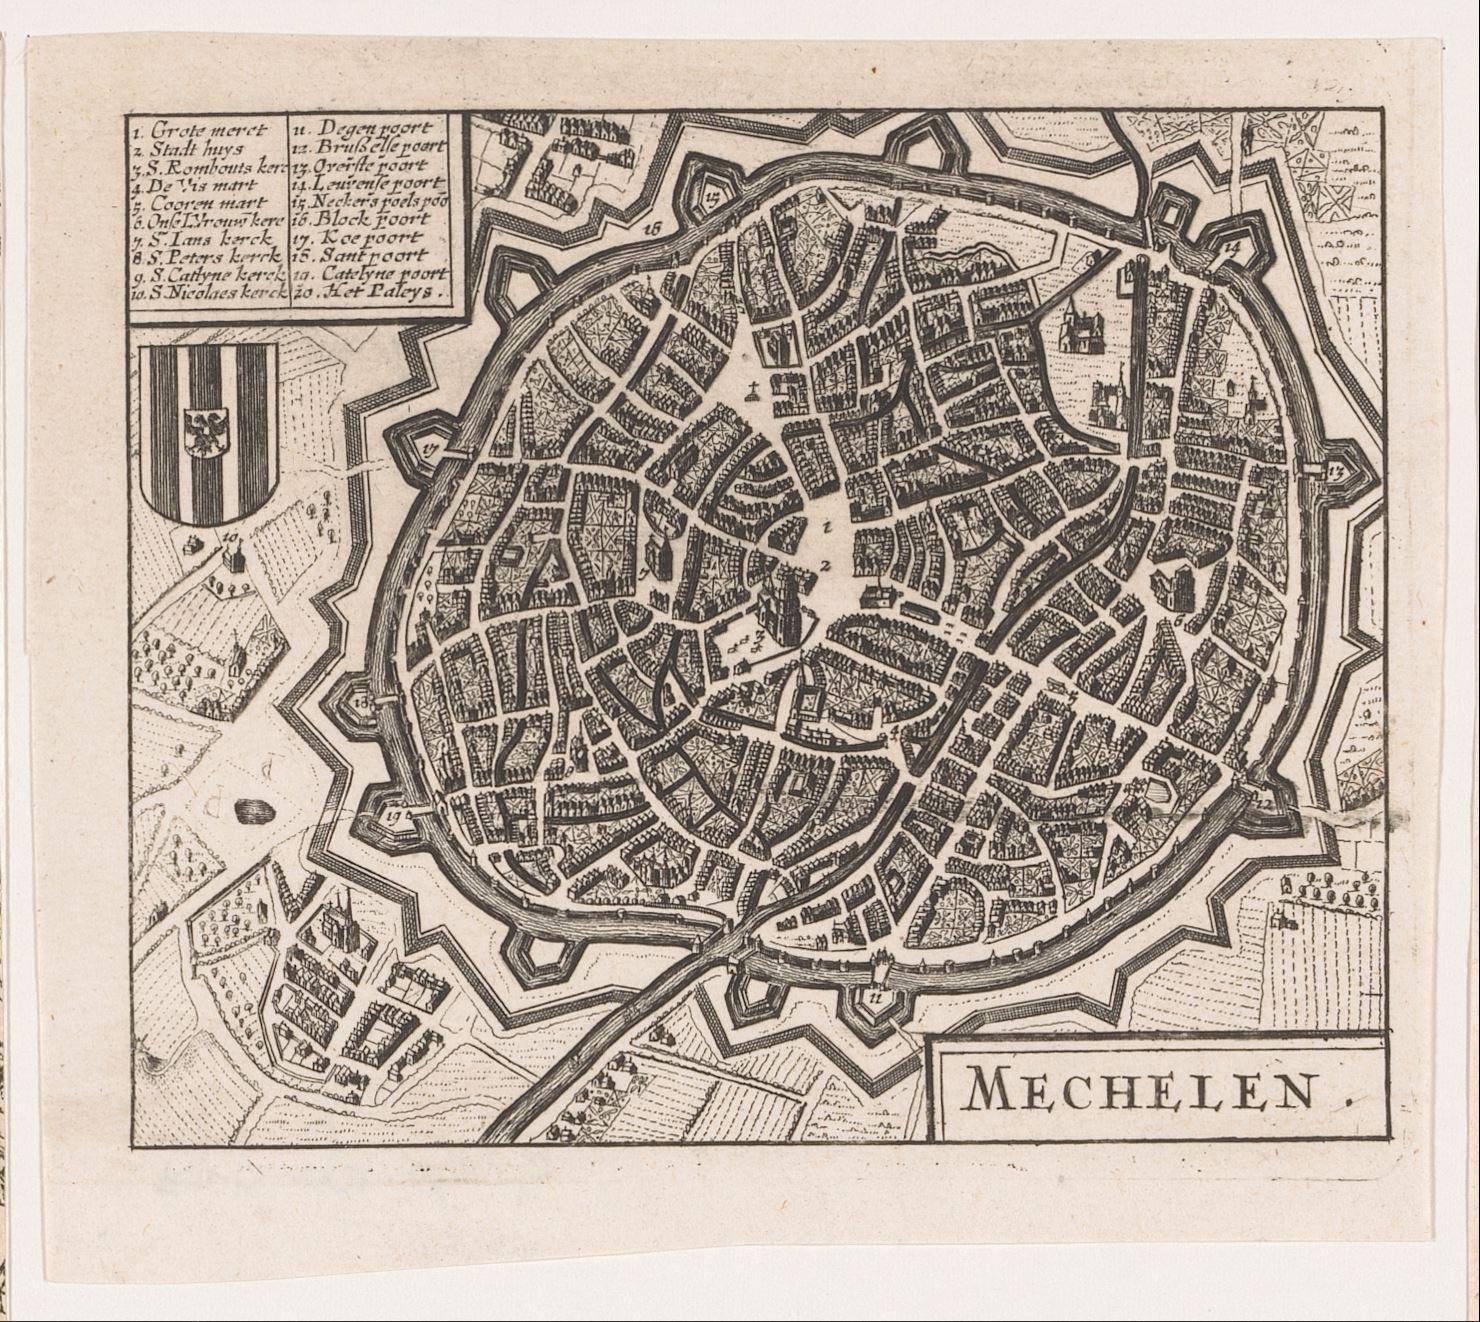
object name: print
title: Mechelen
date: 1652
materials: paper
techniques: etching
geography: amsterdam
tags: maps of cities, mechelen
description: Plattegrond uit: Guicciardini, Lodovico. Belgicae sive Inferioris Germaniae, descriptio (...). Amsterdam: Johannes Janssonius junior, 1652. Komt ook voor in: Caert en stedeboexken van Nederlandt. Amsterdam: Jan Janssen Brouwer, 1652.